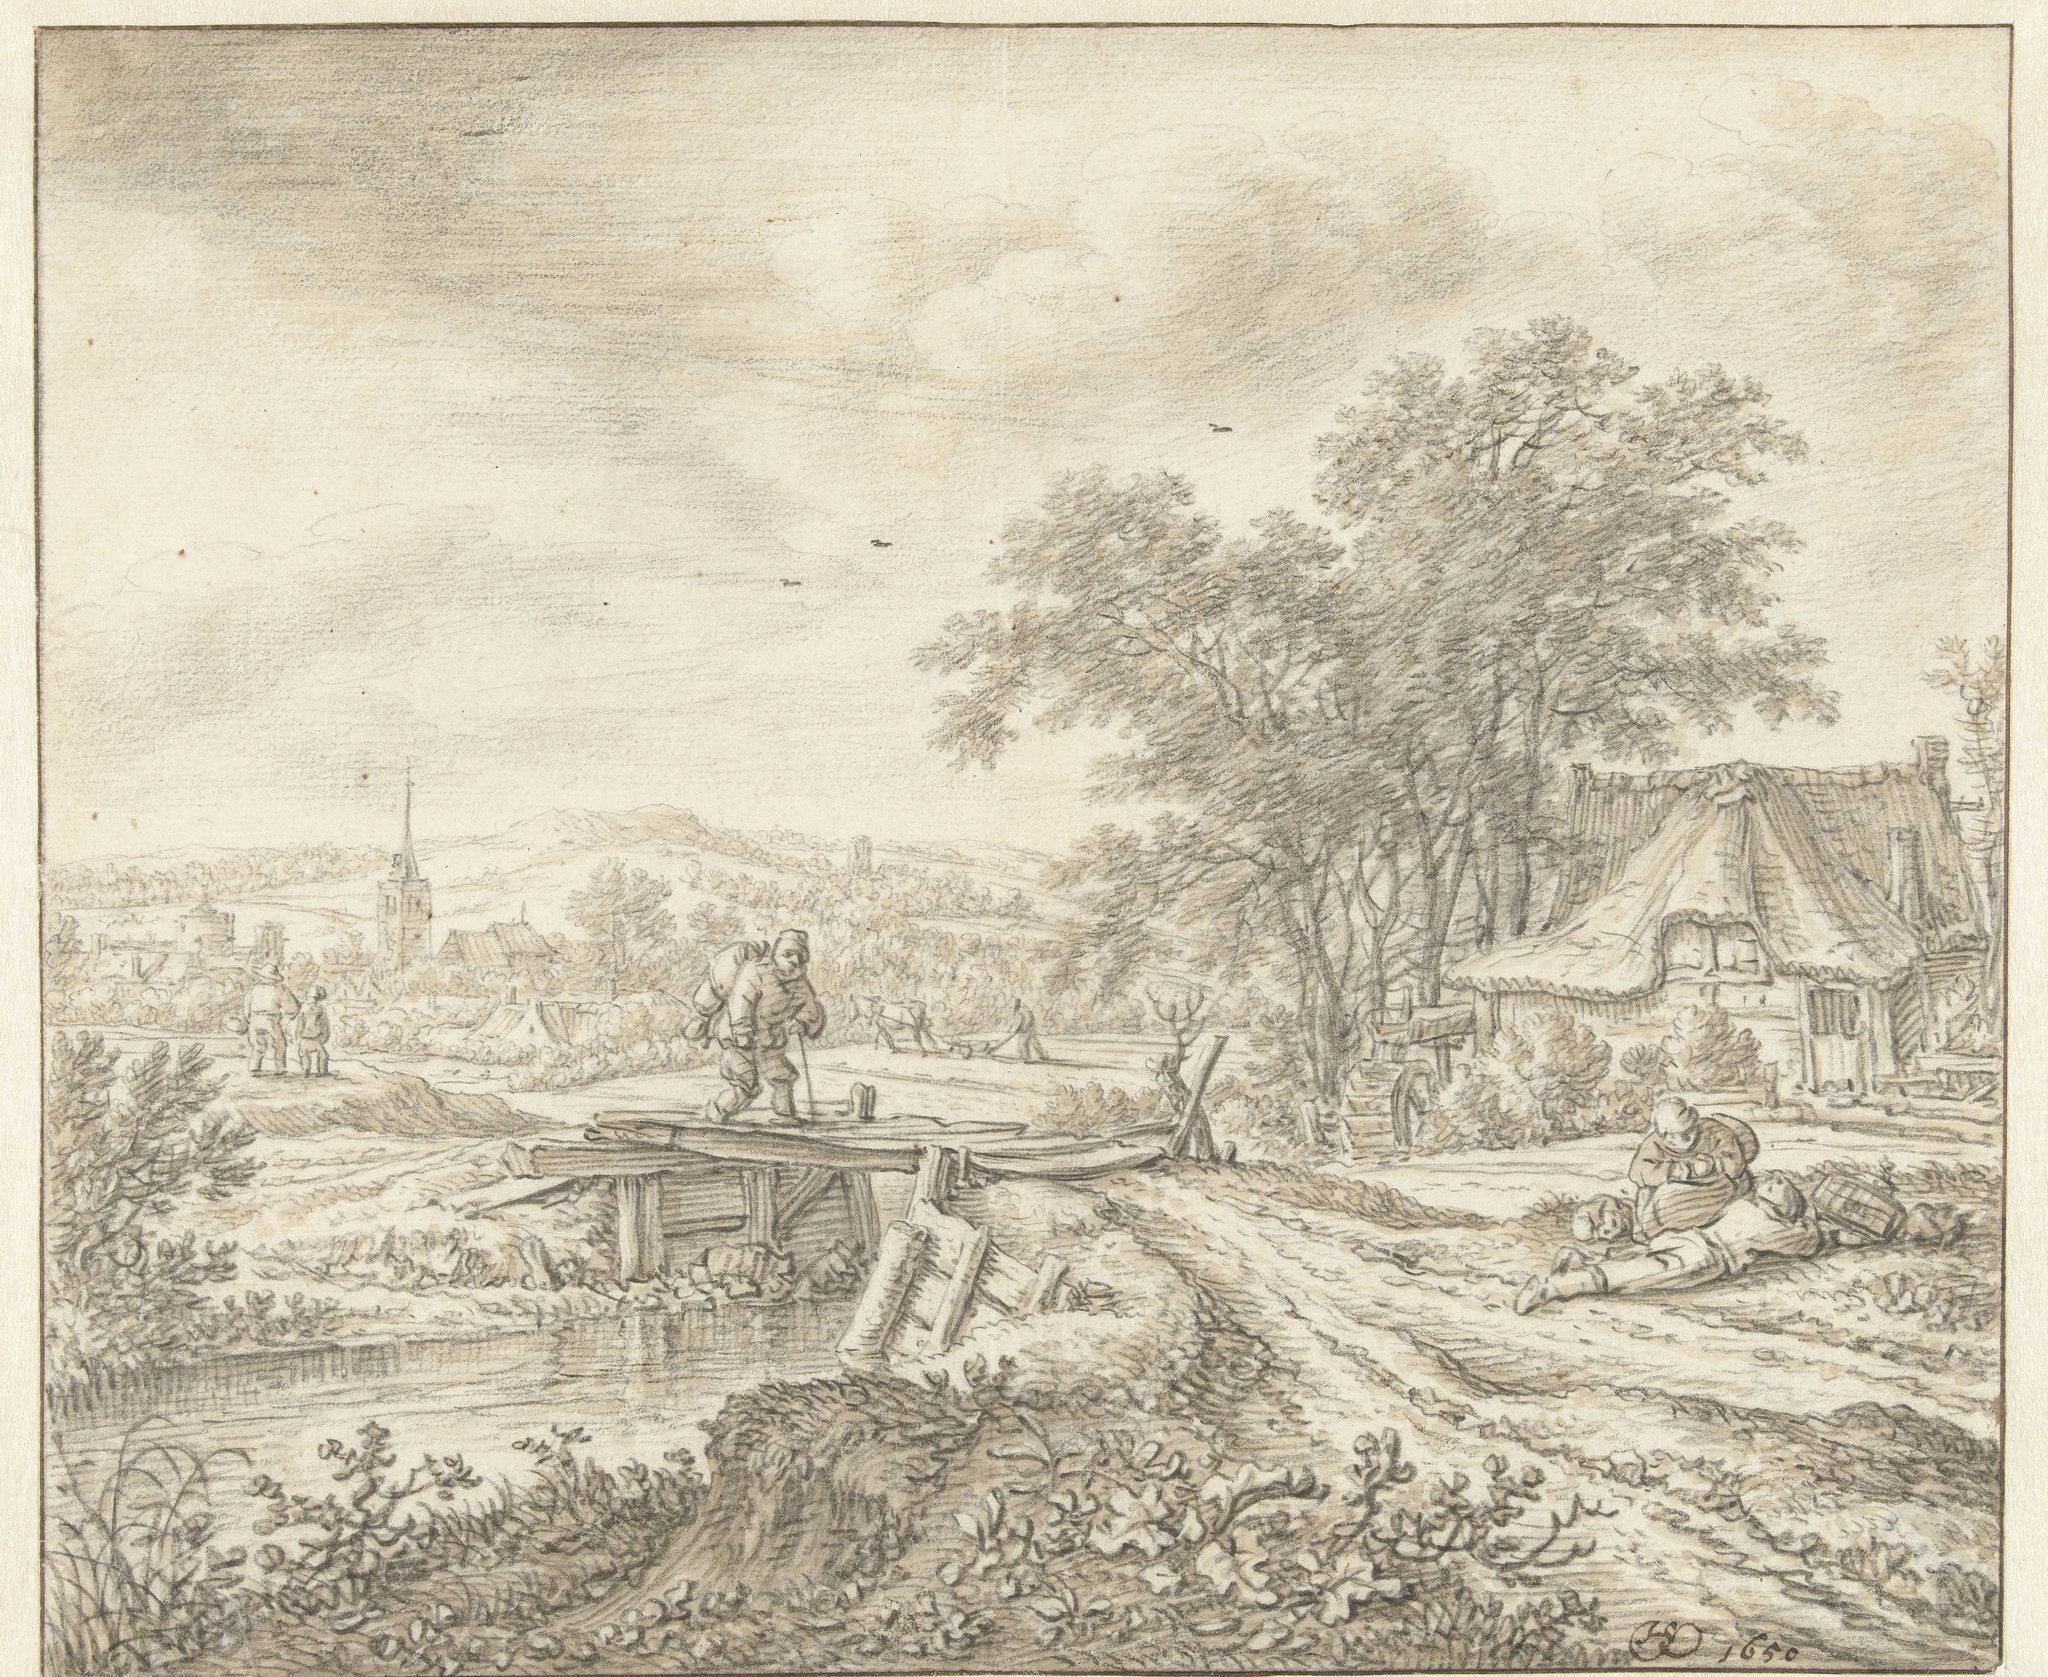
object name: drawing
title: Heuvellandschap met een boerderij bij een bruggetje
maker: herman saftleven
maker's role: draughtsman, painter, print maker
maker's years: 1609-1685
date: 1650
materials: chalk, paper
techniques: brush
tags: landscape with bridge, viaduct or aqueduct, landscape with ruins